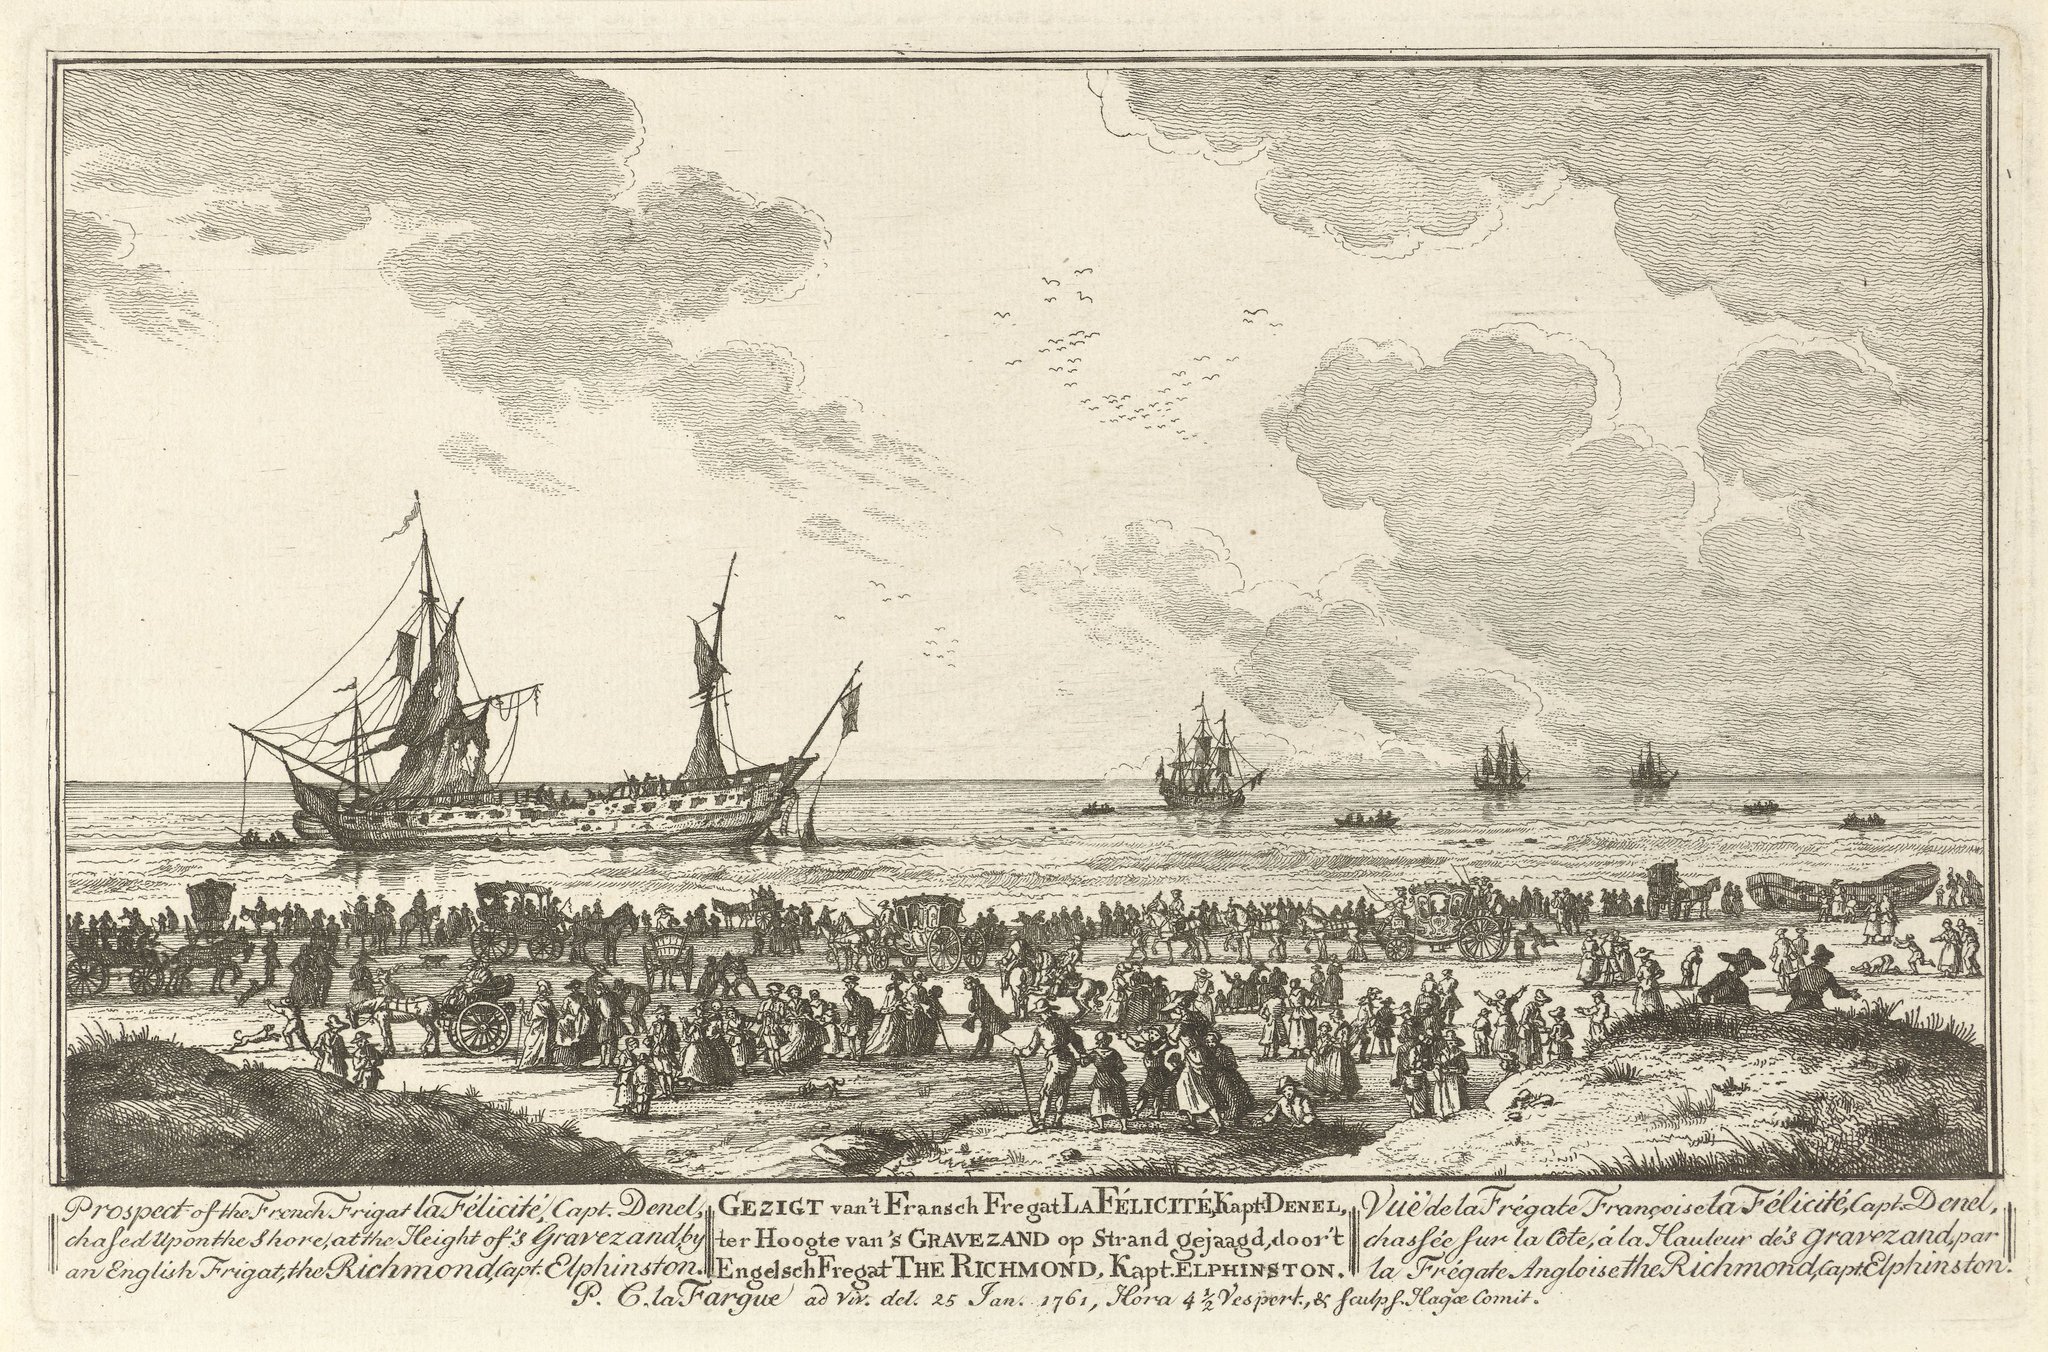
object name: print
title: Gezigt van 't Fransch Fregat La Félicité, Kapt. Denel, ter Hoogte van 's Gravezand op Strand gejaagd, door 't Engelsch Fregat The Richmond, Kapt. Elphinston / Prospect of the French Frigat la Félicité (...) / Vuë de la Frégate Françoise la Félicité (...)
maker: paulus constantijn la fargue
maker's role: draughtsman, painter, print maker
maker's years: 1729-1782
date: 1761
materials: paper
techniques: etching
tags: ships, boats on land, beached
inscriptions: collector's mark: Lugt 2228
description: Het Franse fregat La Félicité (onder bevel van kapitein Denel) door het Engelse fregat The Richmond (onder bevel van kapitein Elphinston) bij 's-Gravenzande op het strand gejaagd, 25 januari 1761. Op het strand kijkt een grote groep belangstellenden toe. In het onderschrift de titels in het Engels, Nederlands en Frans.